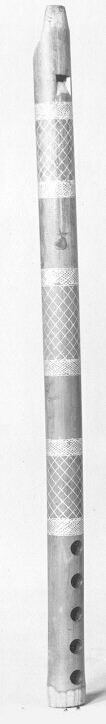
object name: algoja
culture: indian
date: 1867-1900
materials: wood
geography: india